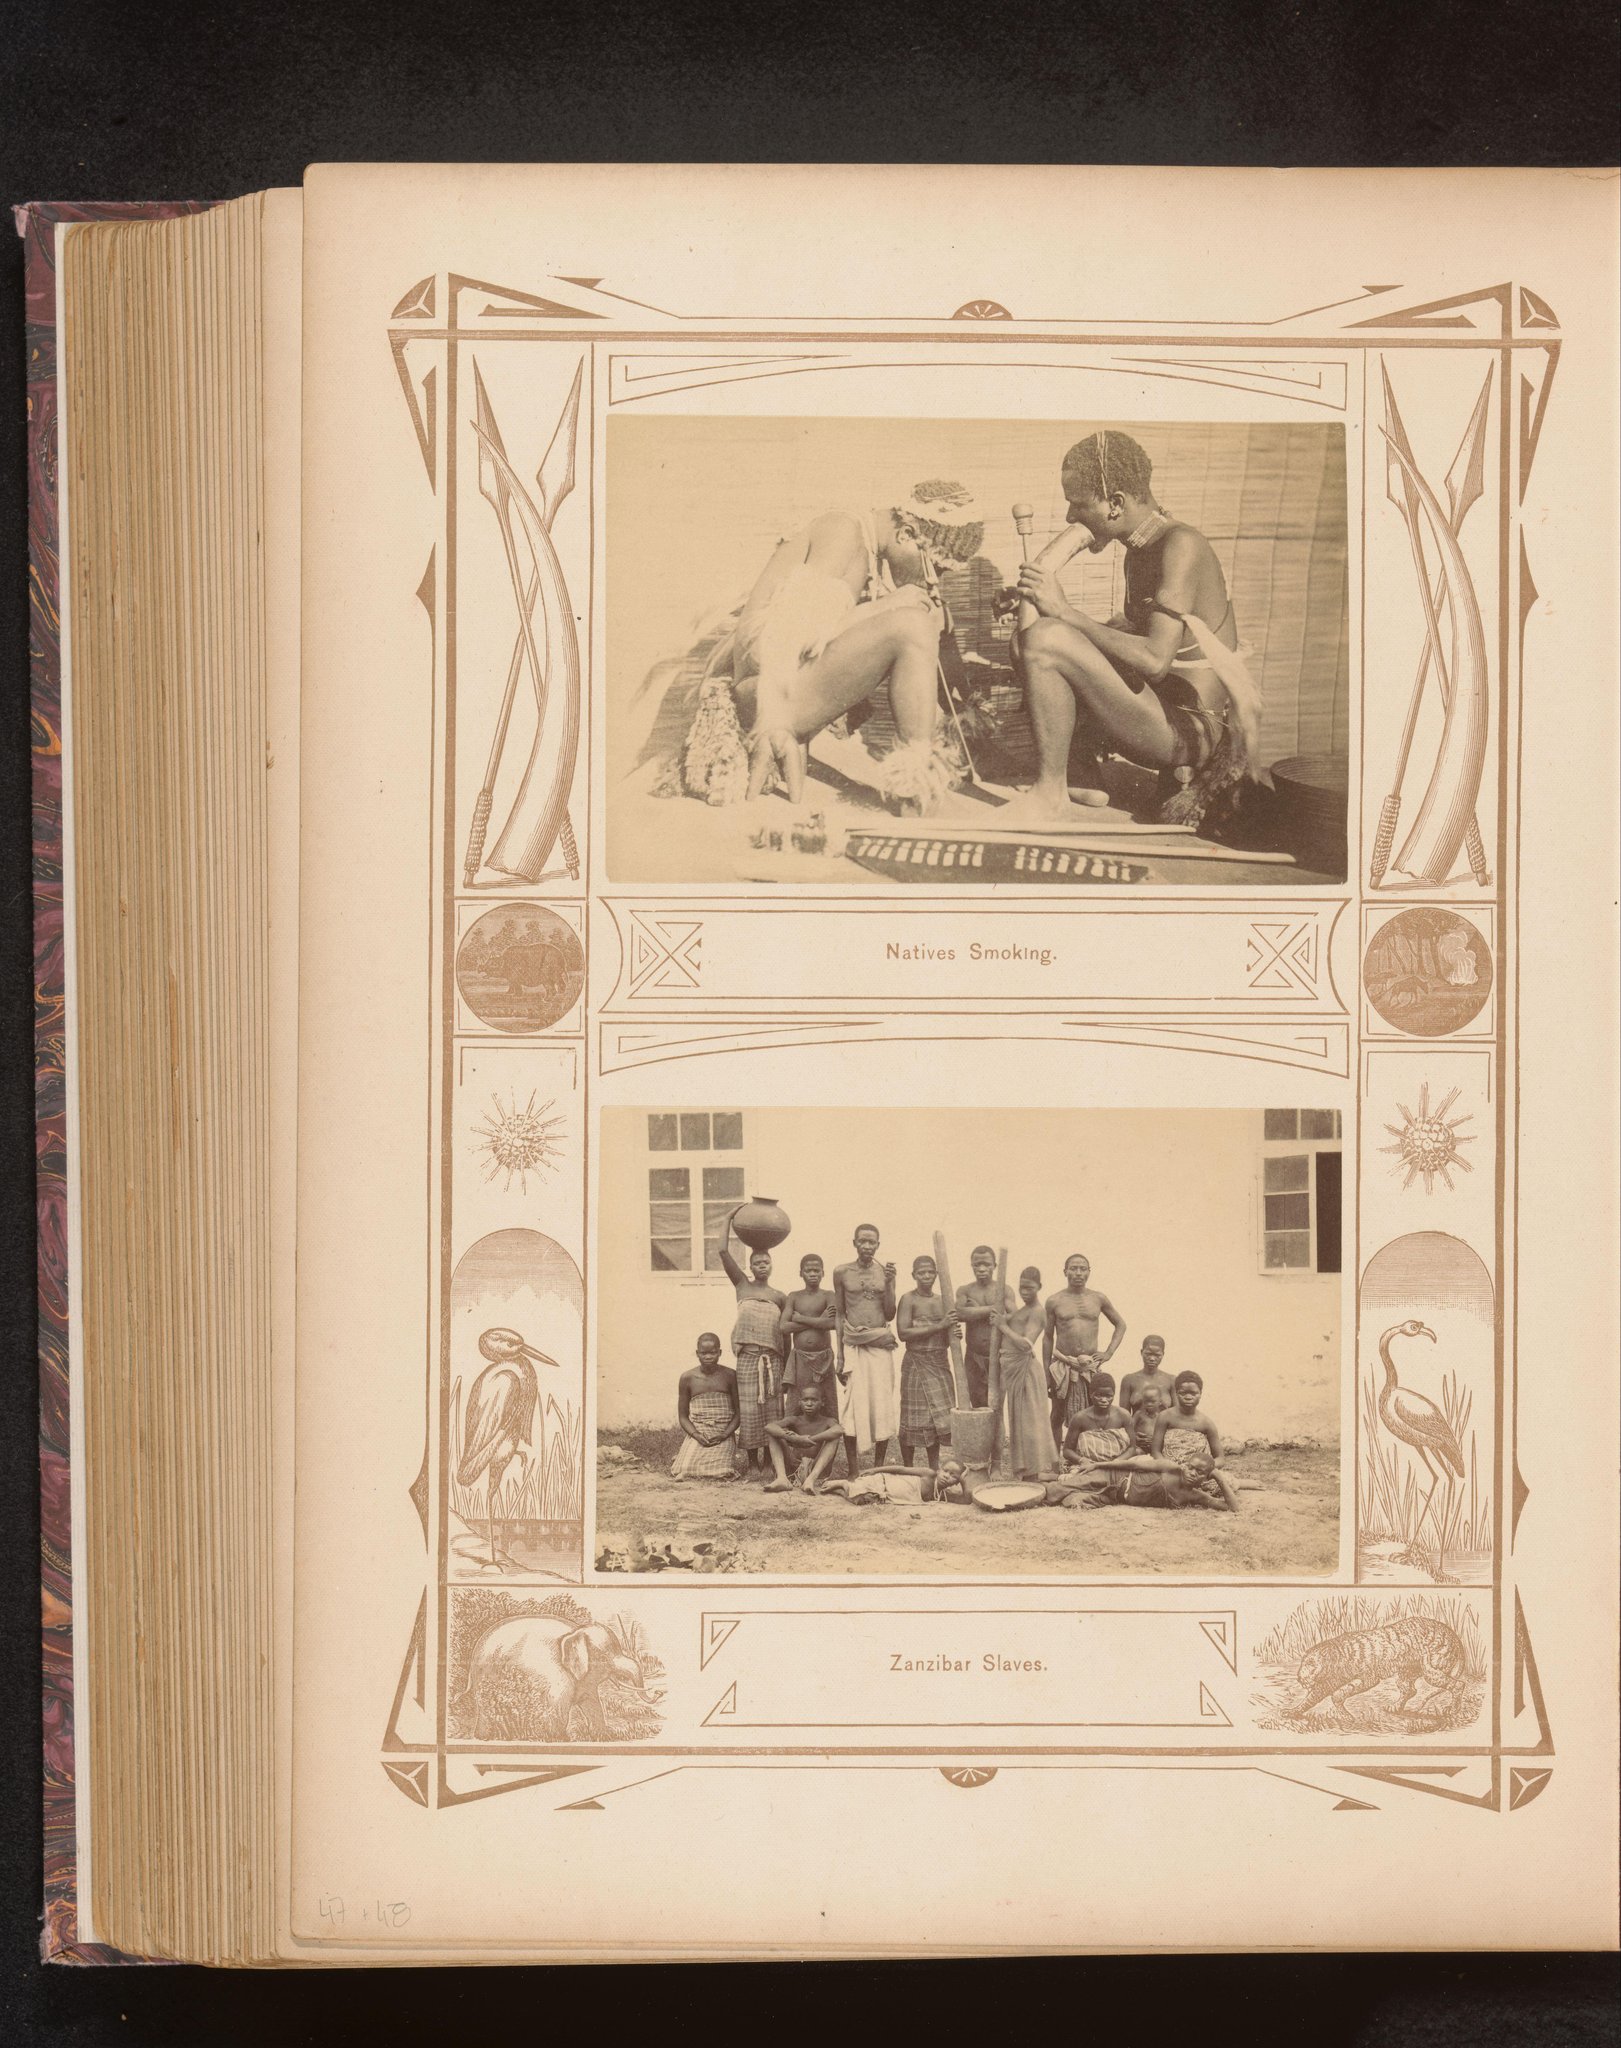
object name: photograph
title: Portret van een groep onbekende Afrikaanse tot slaafgemaakte personen uit Zanzibar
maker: Anonymous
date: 1877-1882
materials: photographic support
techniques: albumen print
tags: africans, adult man, slavery; serfs and enslaved persons, anonymous historical persons portrayed in a group, in a group-portrait